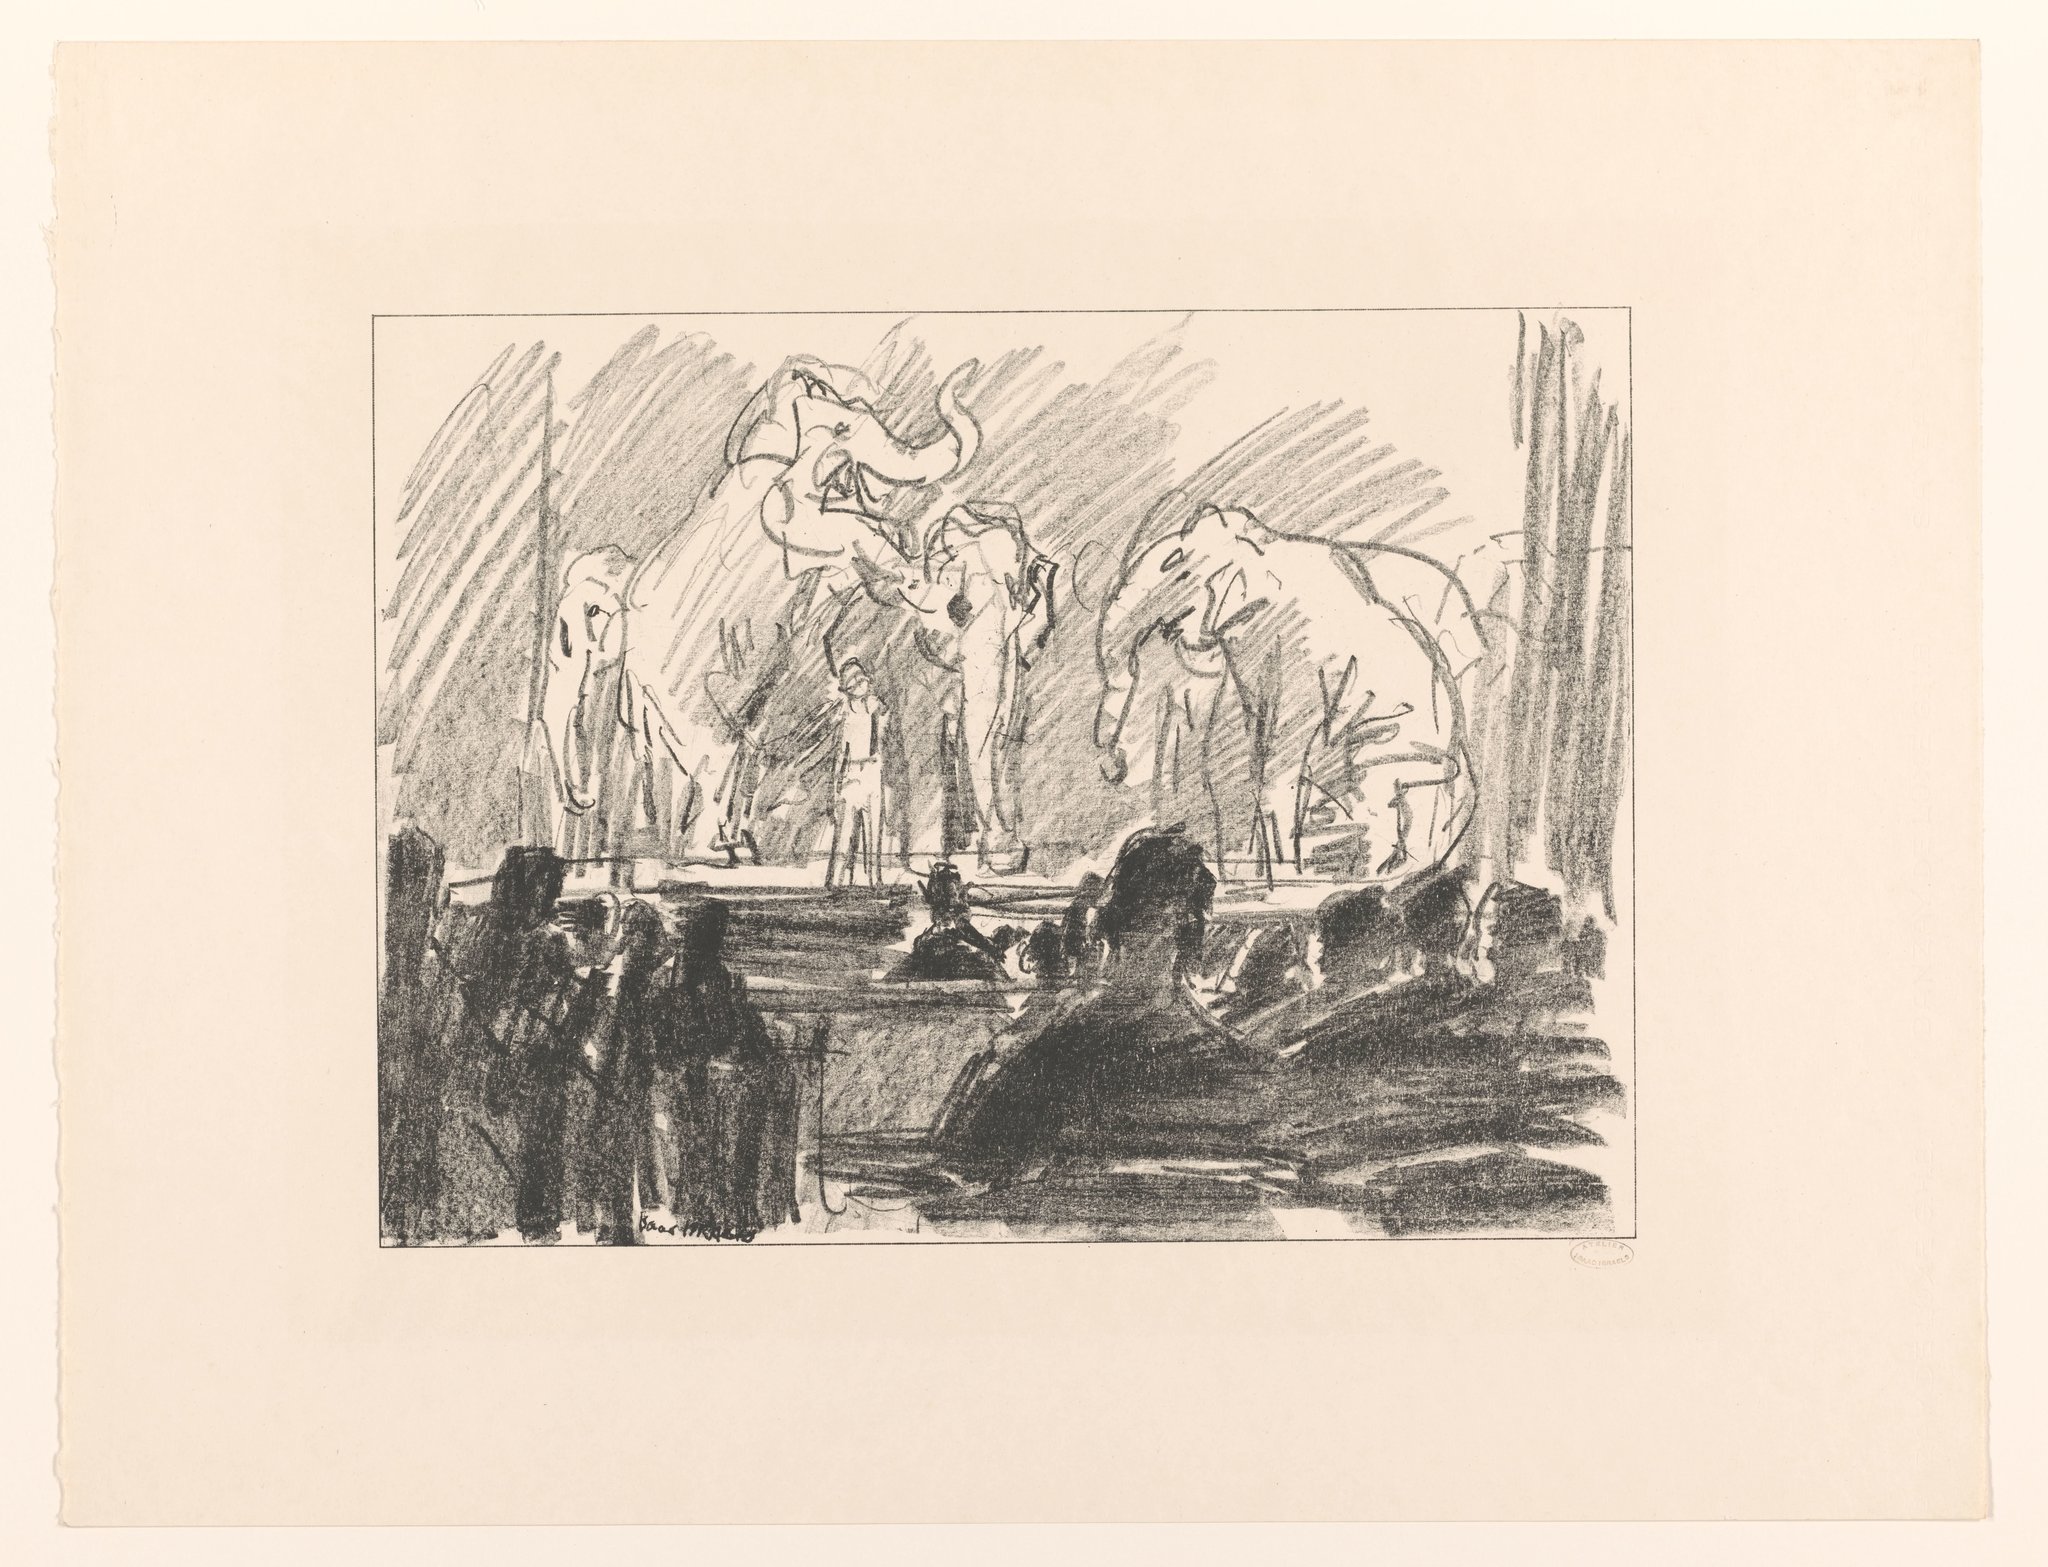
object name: print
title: Circustafereel met olifanten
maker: isaac israels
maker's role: draughtsman, painter, print maker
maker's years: 1865-1934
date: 1875-1934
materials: paper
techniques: lithograph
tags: circus animals, circus, trunked animals: elephant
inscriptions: collector's mark: Lugt 1402a, collector's mark: Lugt 2228